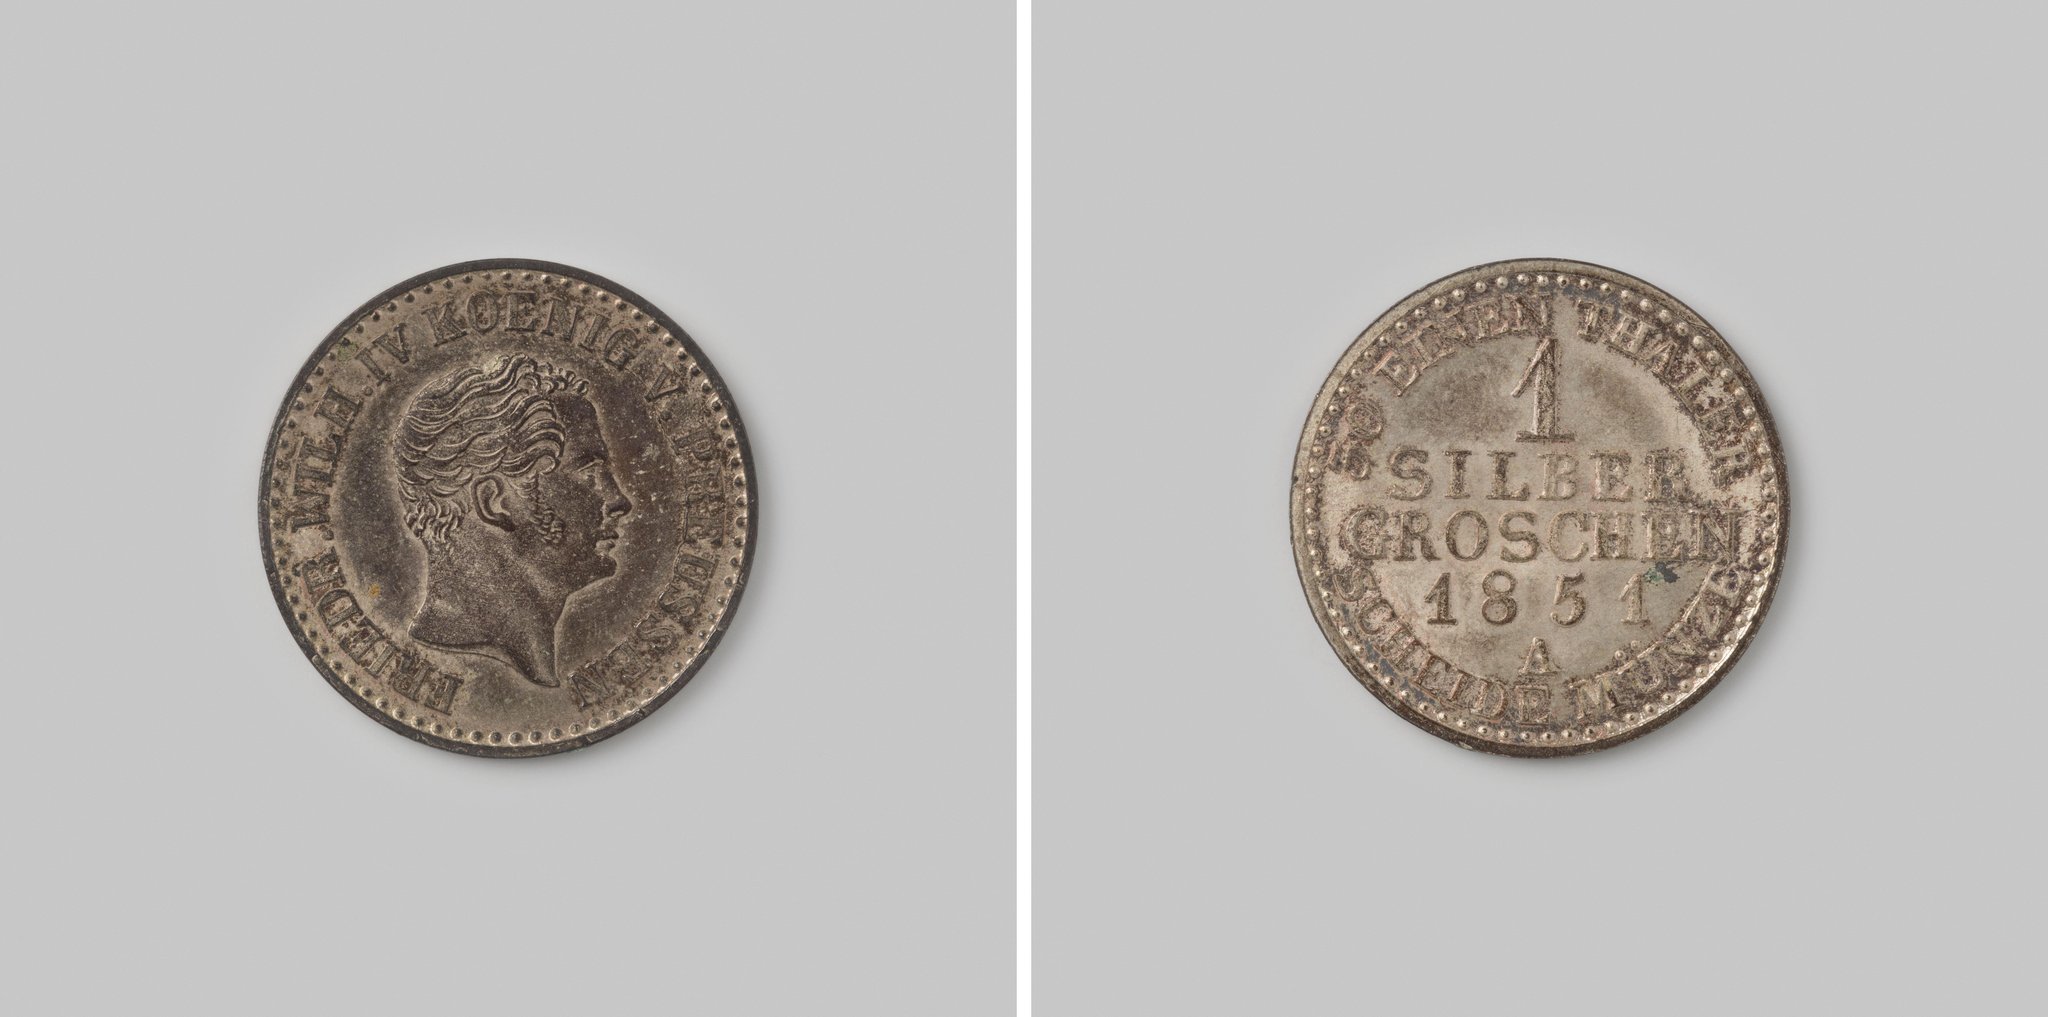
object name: coin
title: Pruisen-Brandenburg, koning Friedrich Wilhelm IV, Silbergroschen, 1851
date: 1851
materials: silver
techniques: striking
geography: berlin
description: Zilveren munt. Voorzijde: hoofd van de koning naar rechts. Keerzijde: waarde-aanduiding in drie regels, waaronder jaartal. Daaronder letter A. Gladde rand.